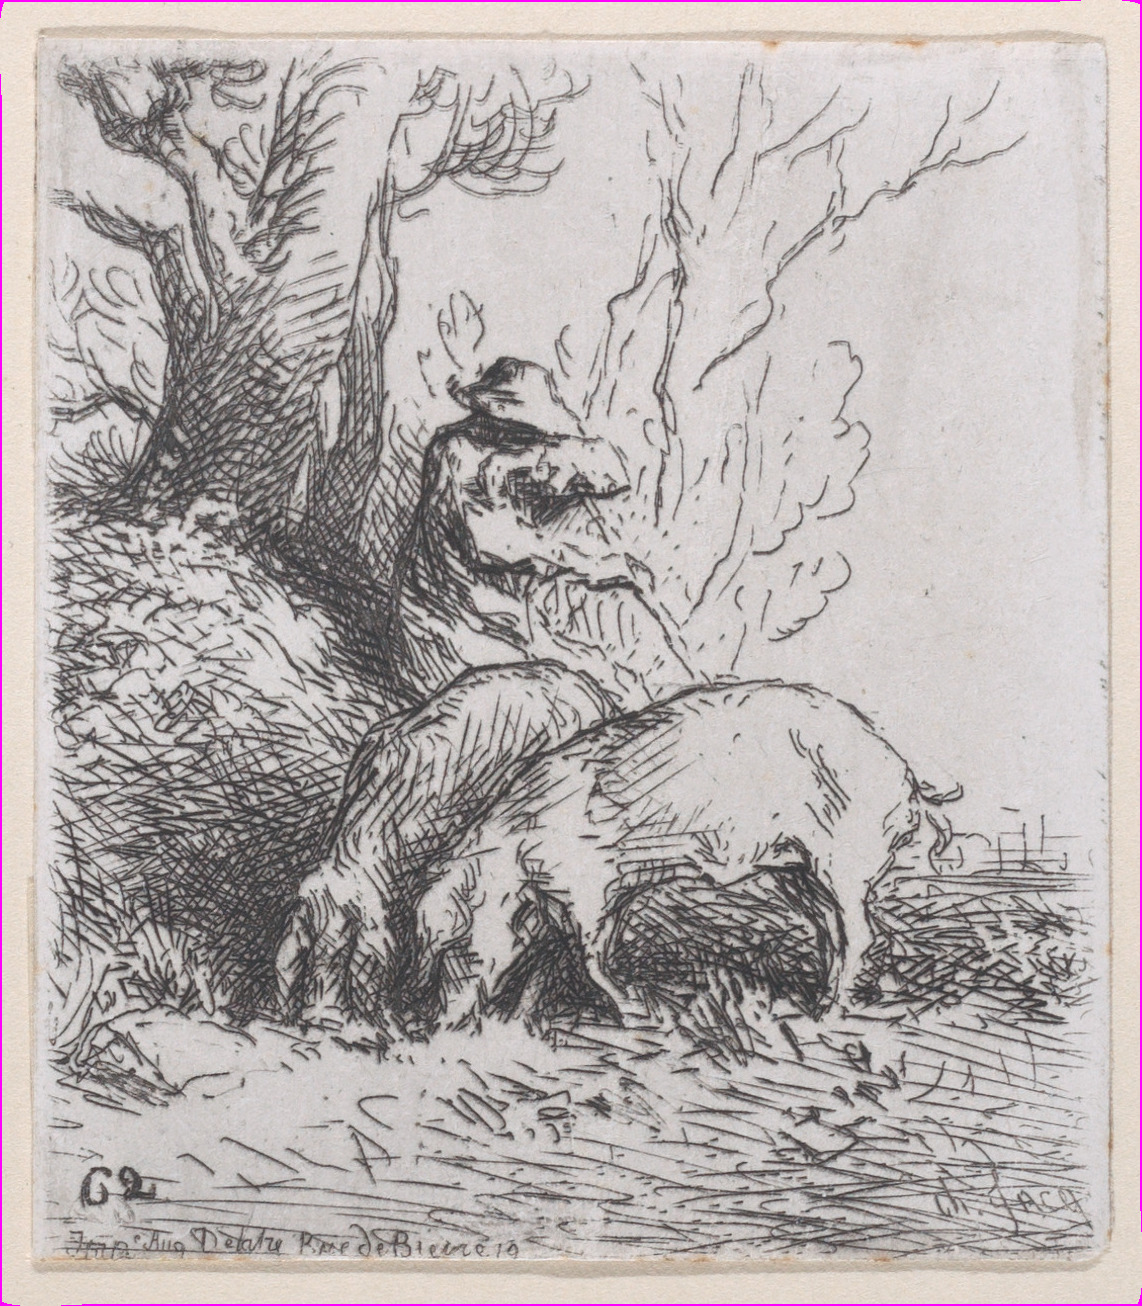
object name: print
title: Swineherd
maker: charles émile jacque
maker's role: artist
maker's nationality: french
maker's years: 1813-1894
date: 1850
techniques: etching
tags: pigs